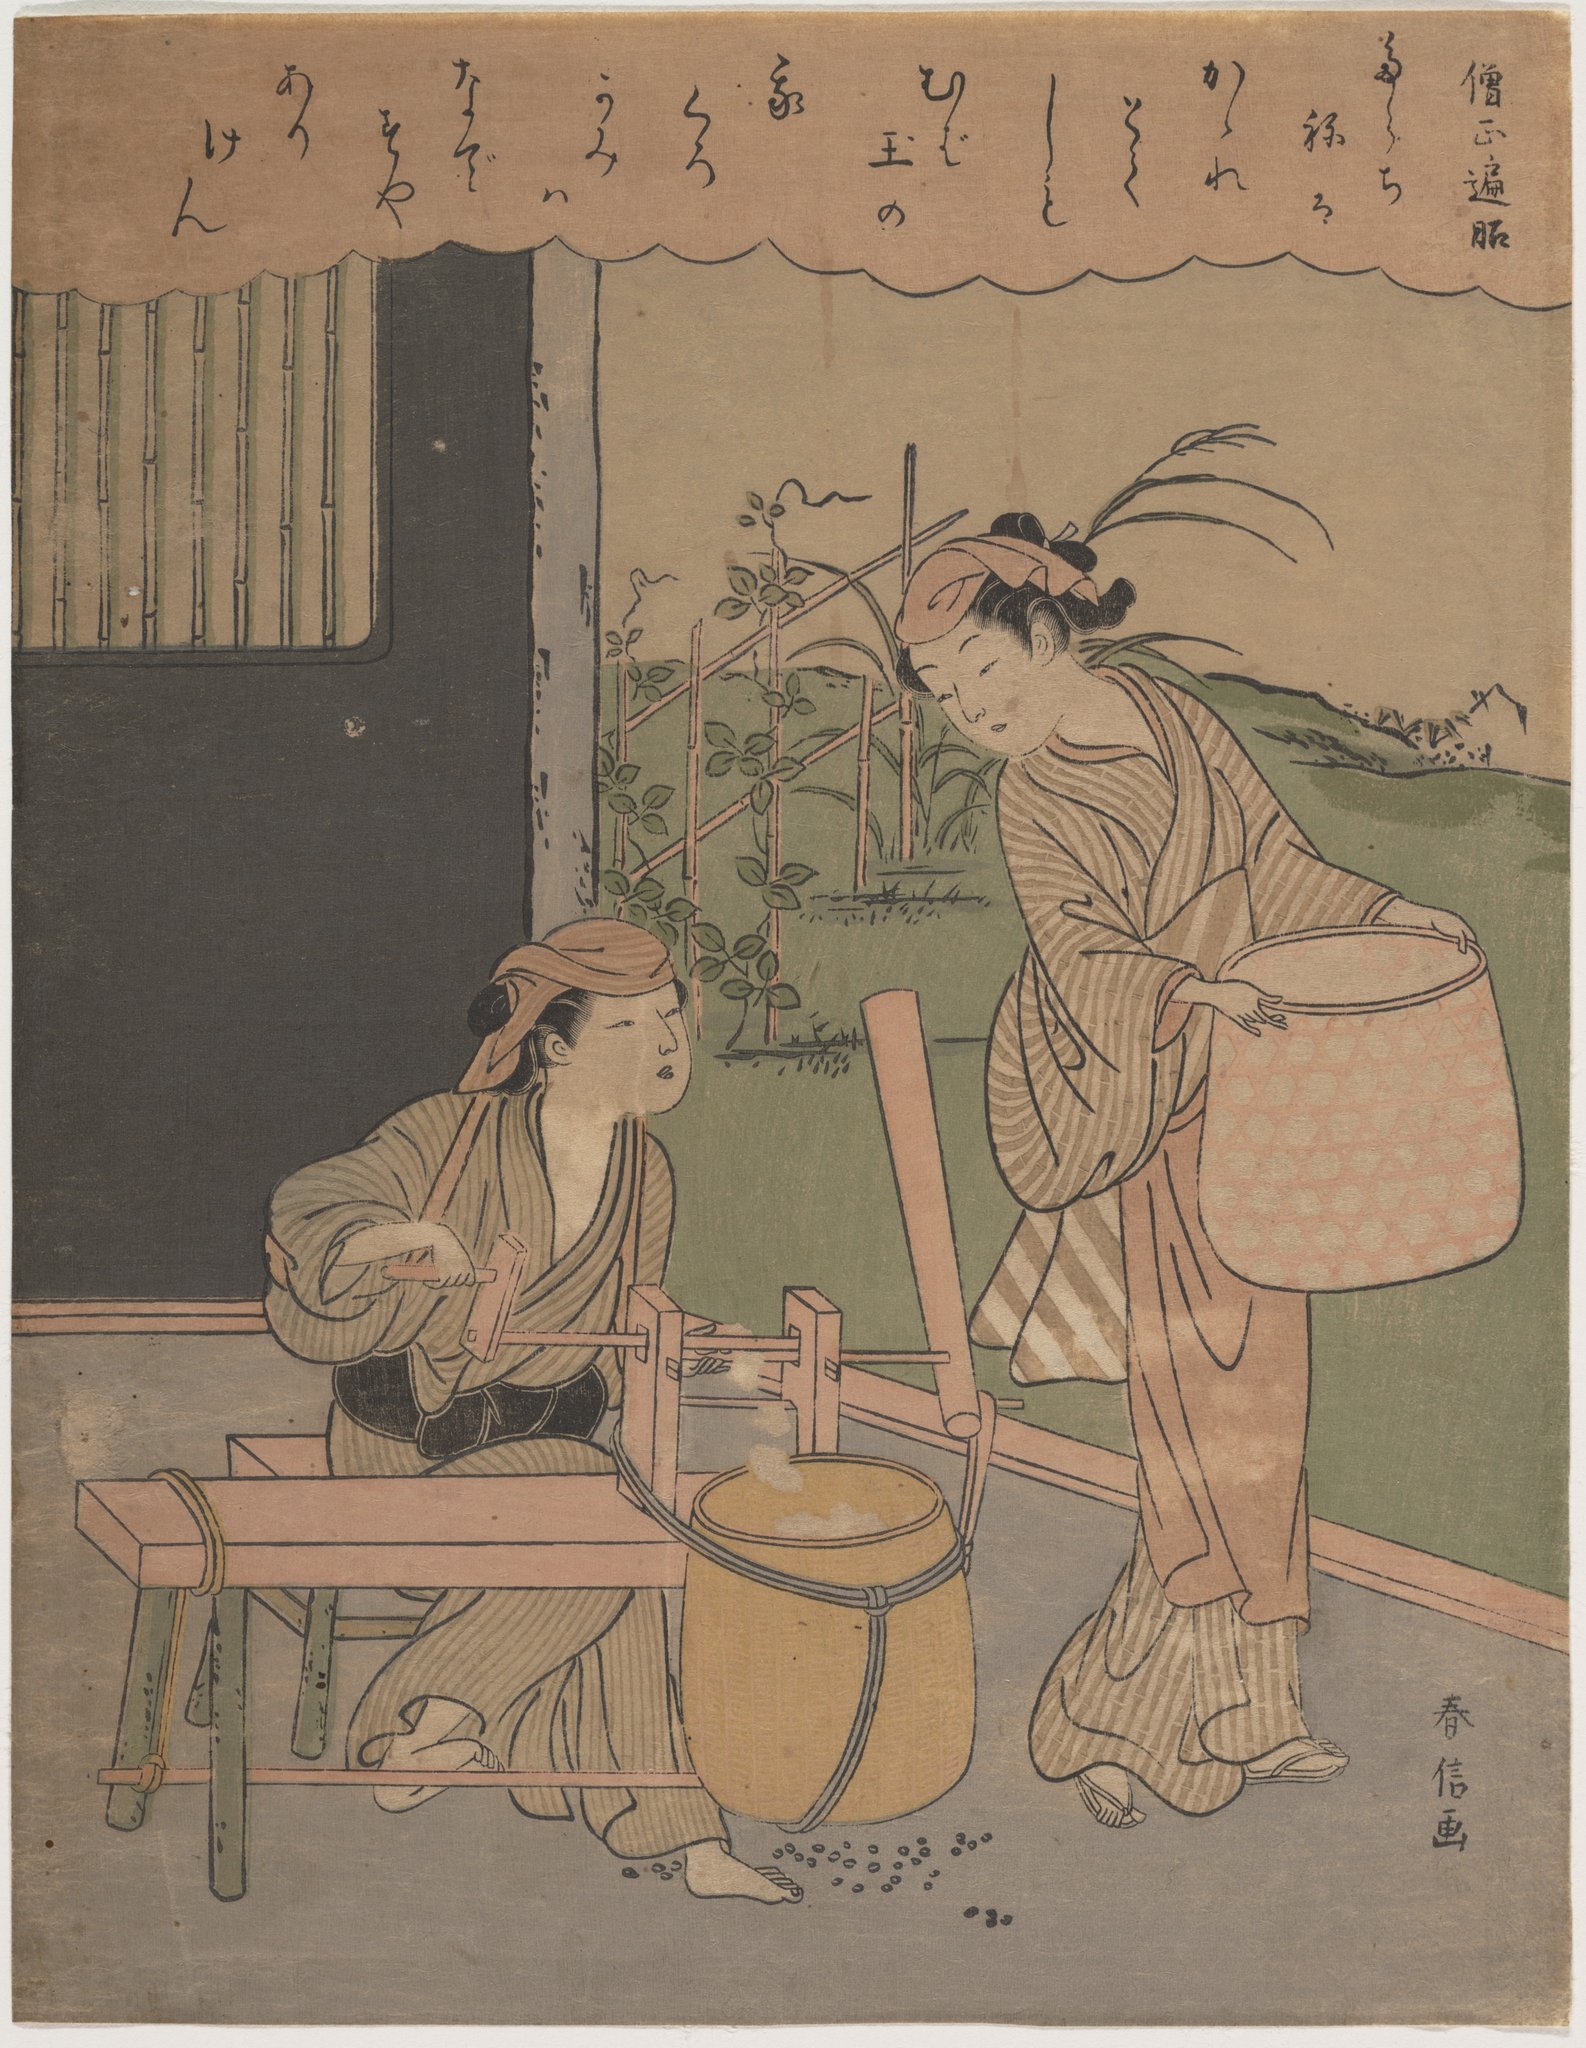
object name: print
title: Poem by Henjō Sojō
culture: japanese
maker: suzuki harunobu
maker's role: artist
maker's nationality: japanese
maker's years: 1725-1770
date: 1766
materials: ink, paper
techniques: woodblock print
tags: women